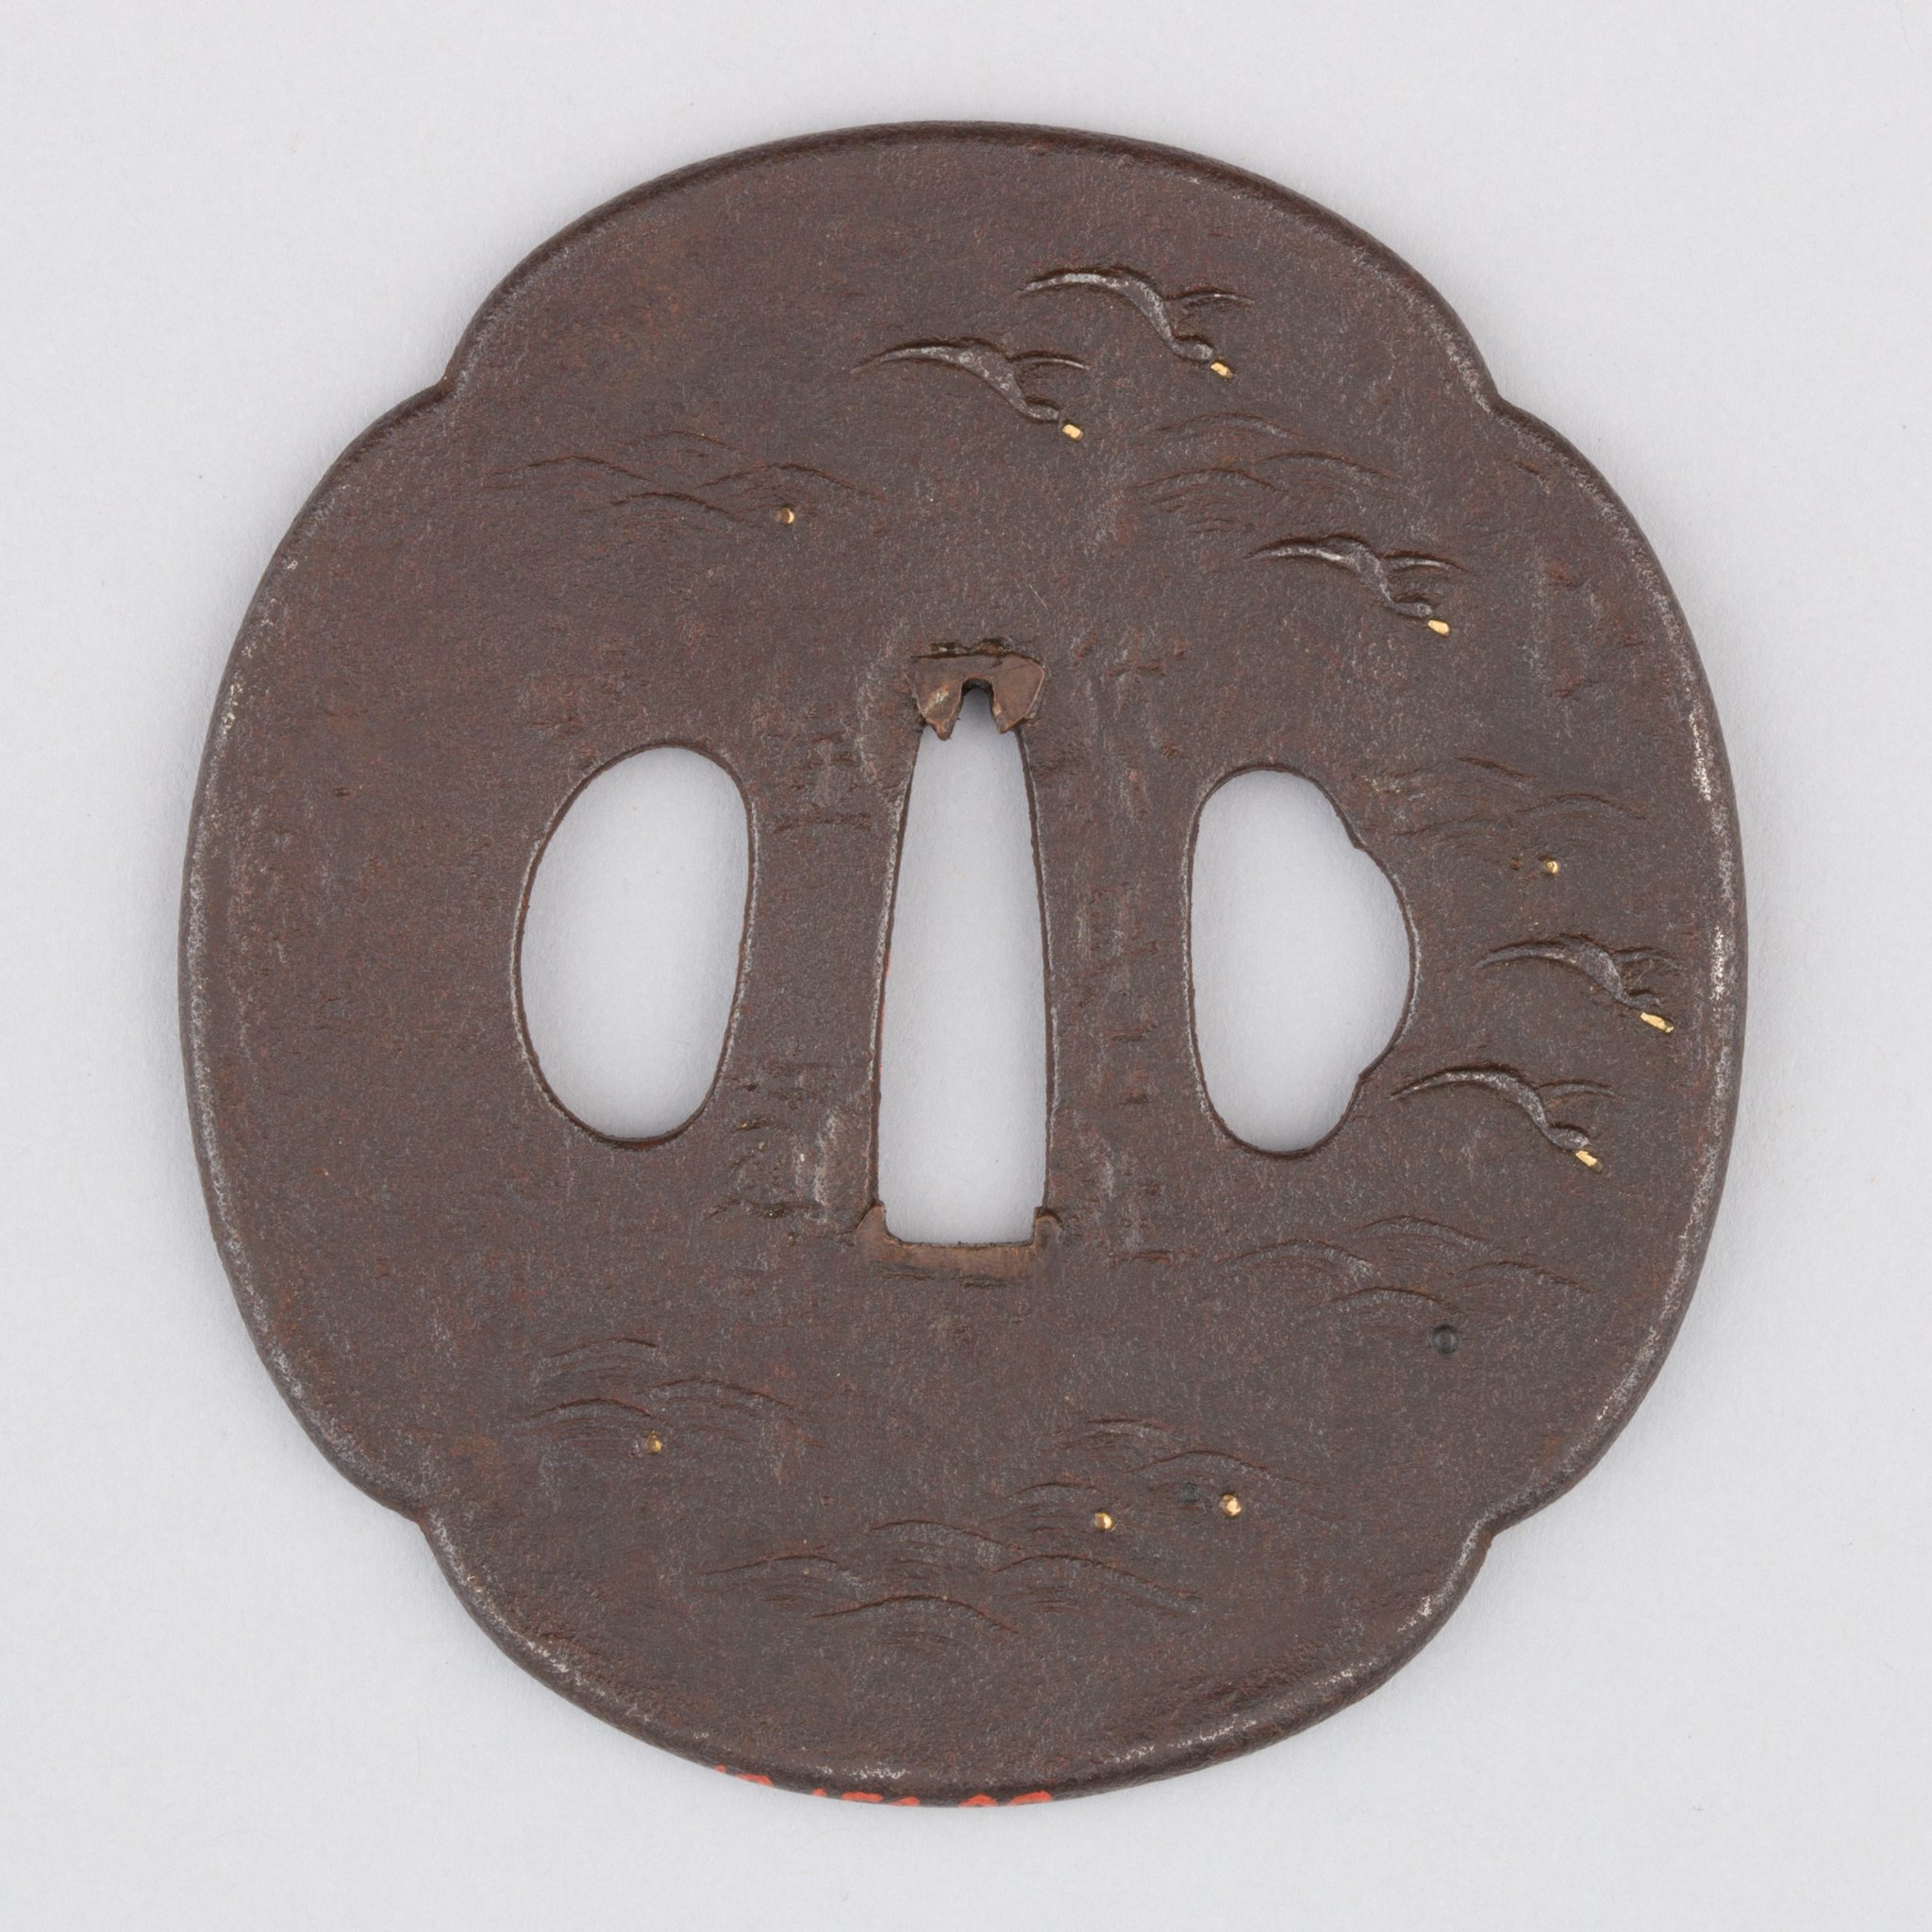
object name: sword guard tsuba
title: Sword Guard (Tsuba)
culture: japanese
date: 1615-1868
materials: copper, iron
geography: japan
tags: geese